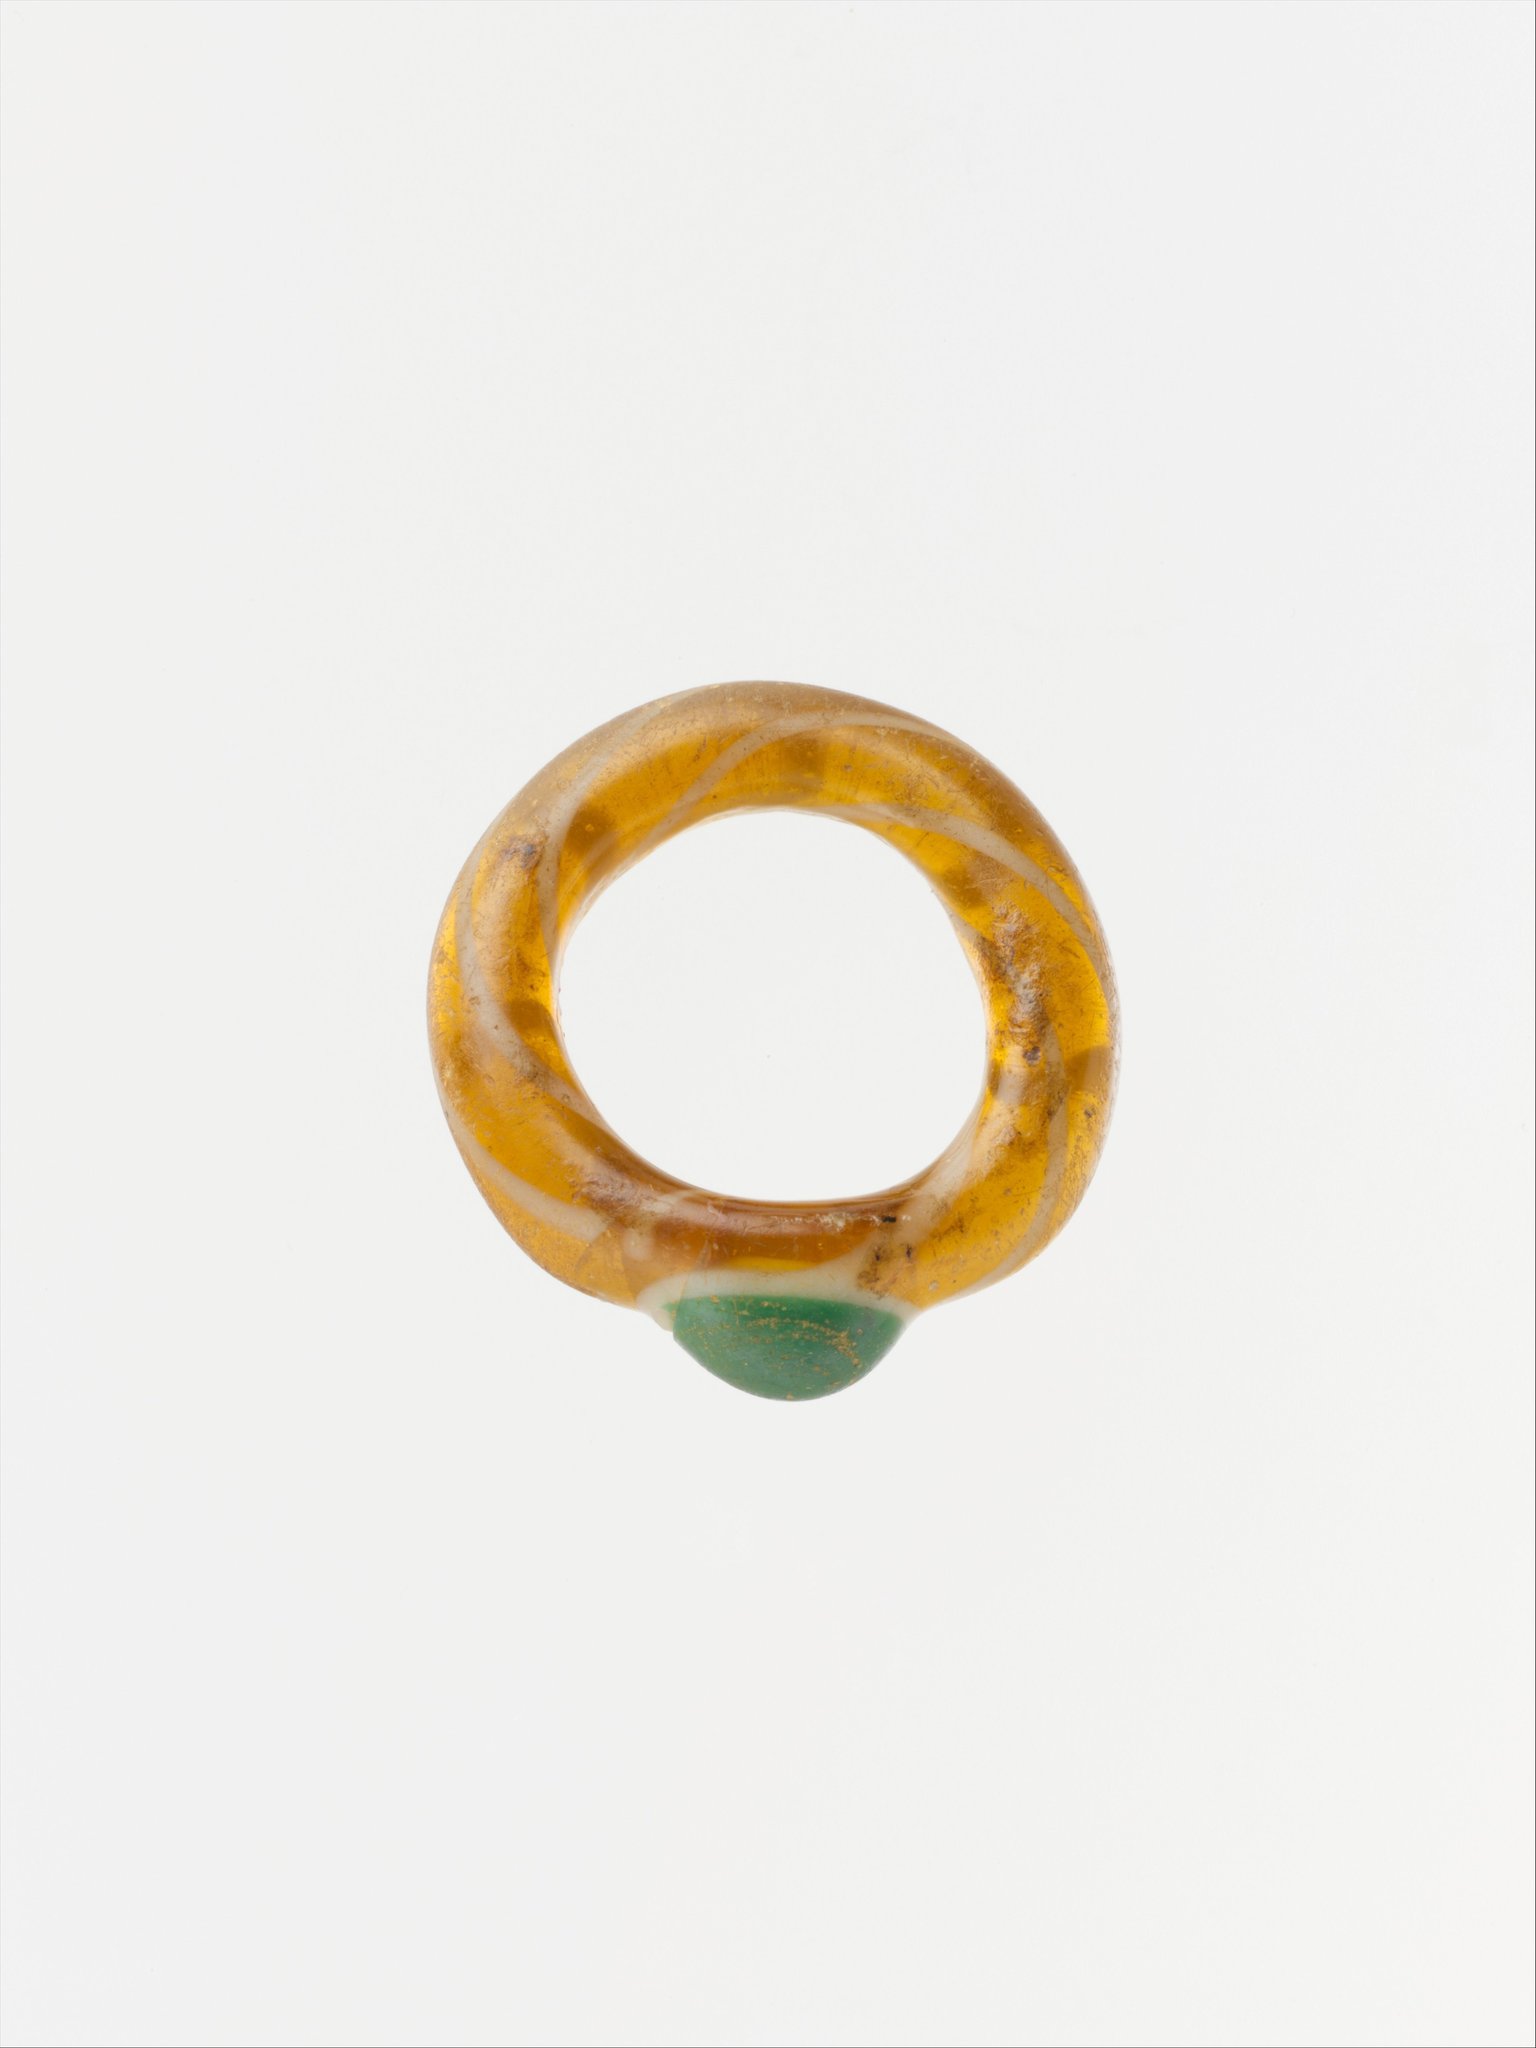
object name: ring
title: Glass finger ring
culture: roman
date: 1-100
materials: glass